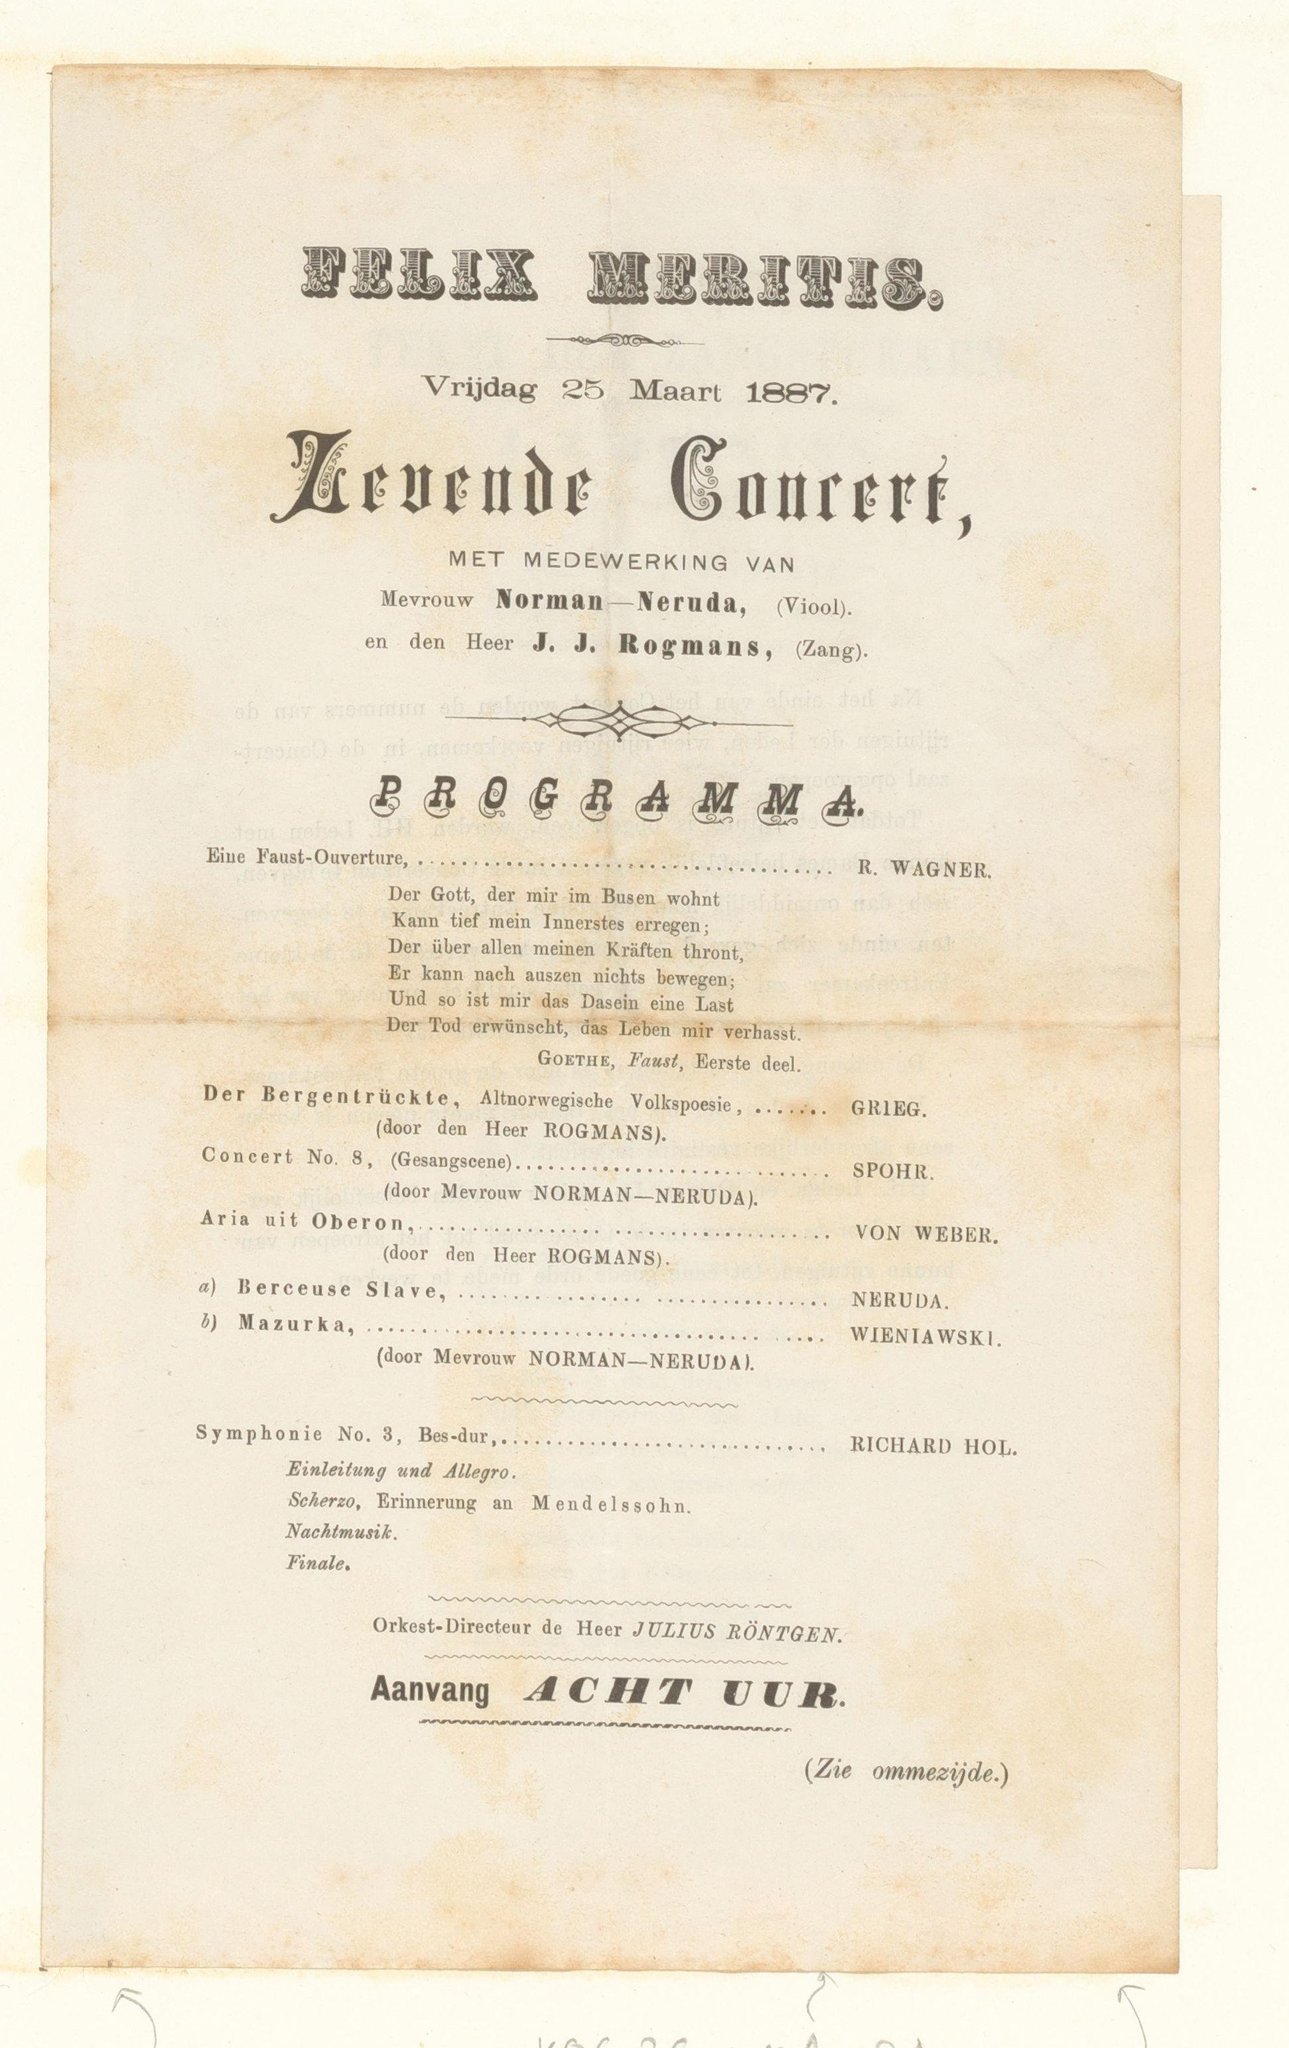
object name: text sheet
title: Programma voor een concert in Felix Meritis op 25 maart 1887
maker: Anonymous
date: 1887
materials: paper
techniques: letterpress printing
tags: utrecht, julius röntgen, listening to music, large group of musicians, orchestra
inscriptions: collector's mark: Lugt 1641, collector's mark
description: Gedrukt programma voor het Zevende Concert door het orkest onder leiding van Julius Röntgen, in Felix Meritis te Amsterdam op 25 maart 1887. Onderwerpsrubrieken binnen de Atlas Zeden en Gewoonten: Muziek en muziekinstrumenten: Varia.